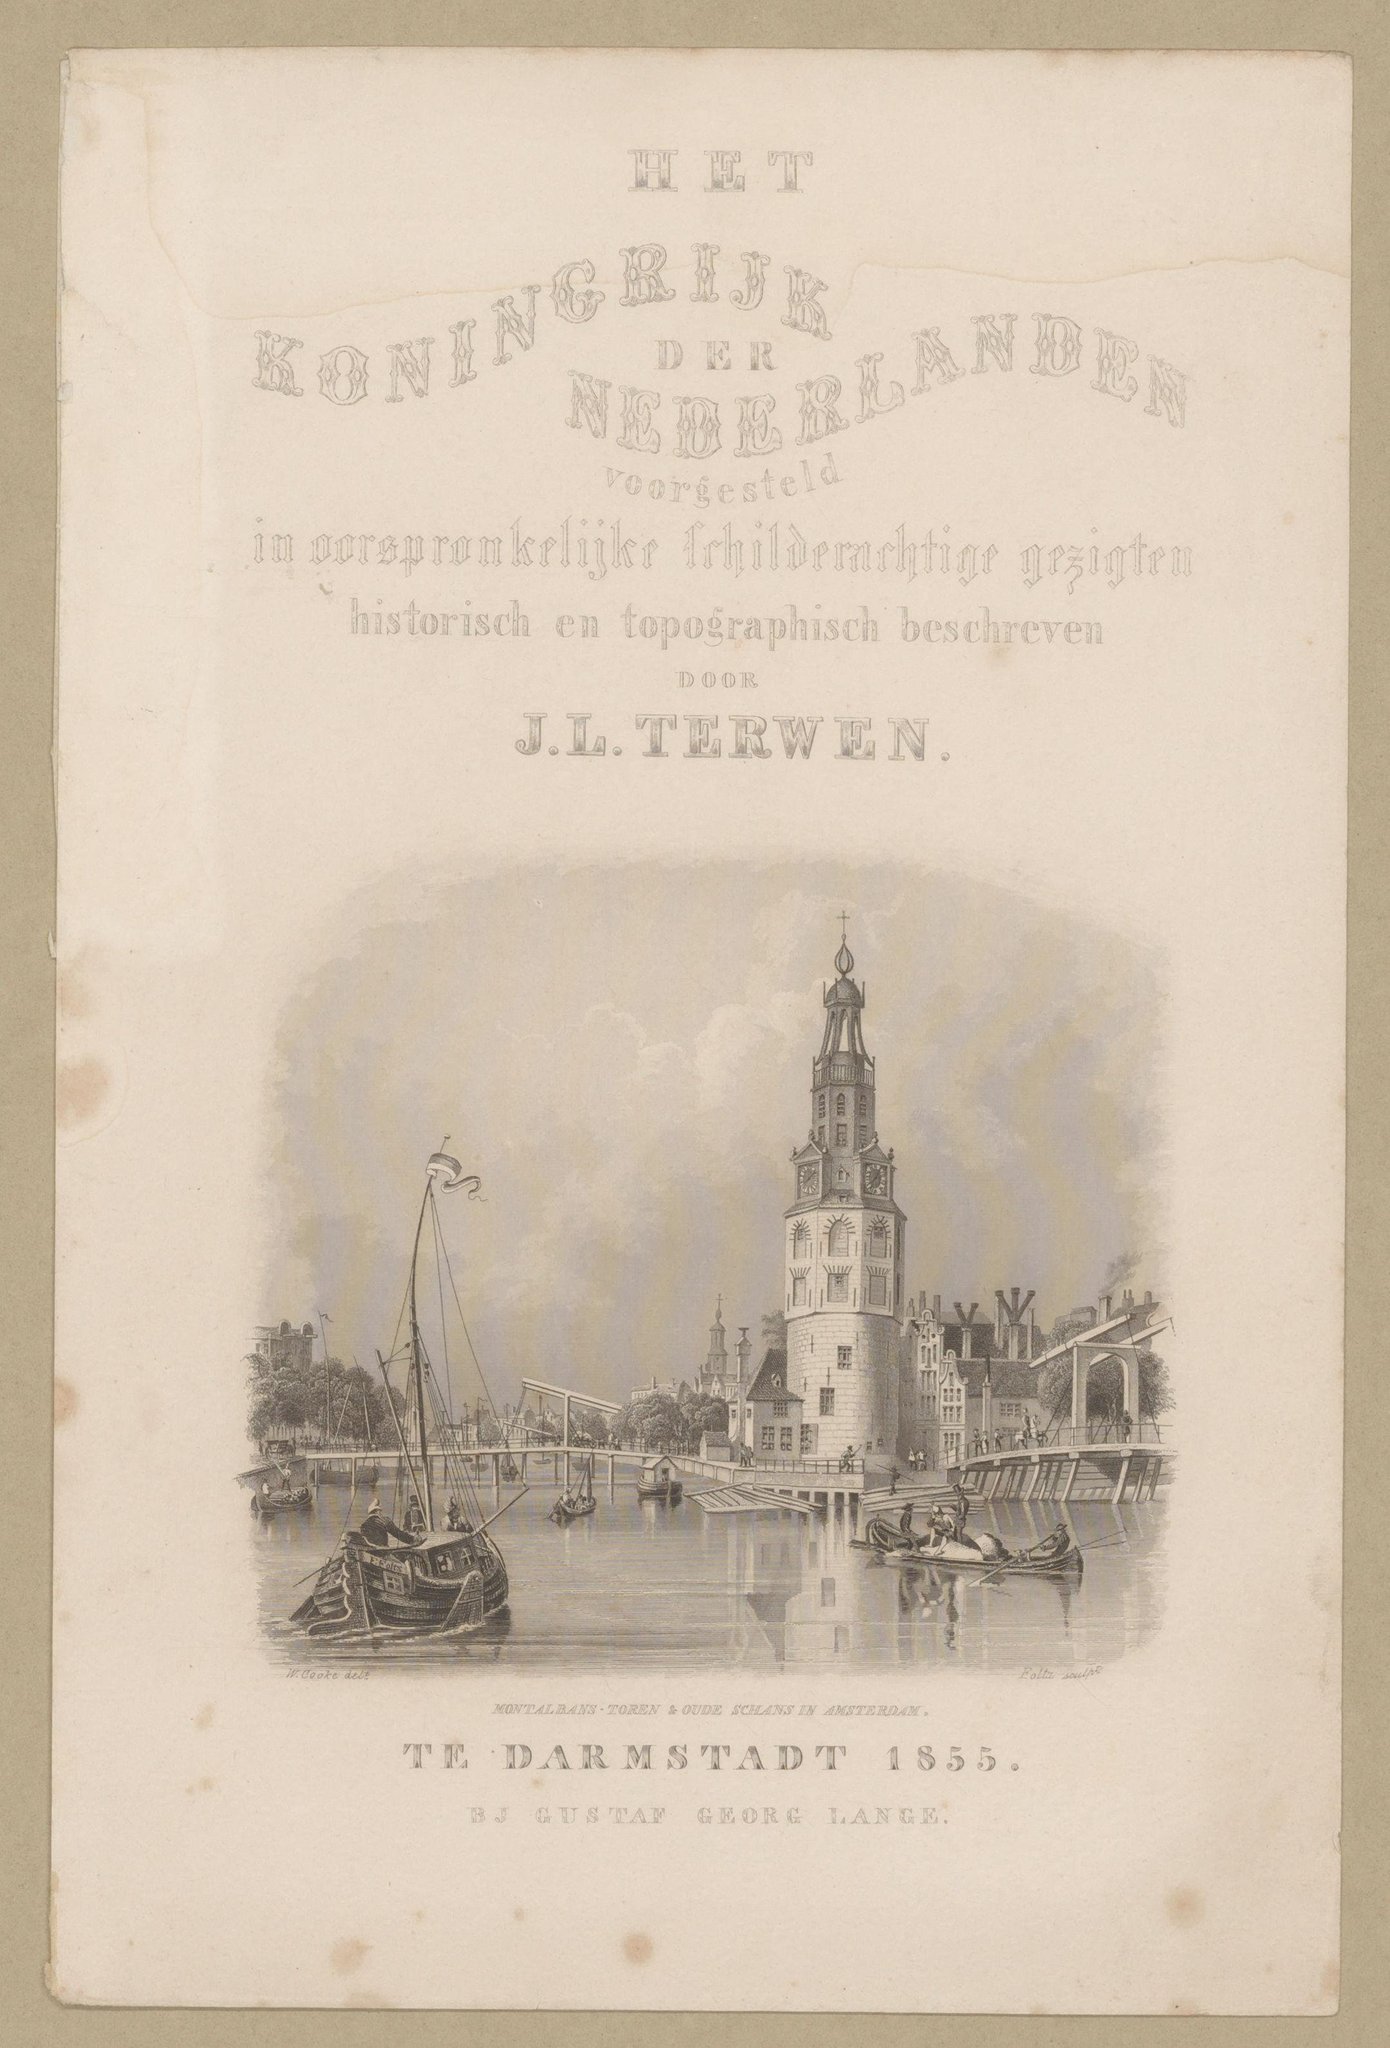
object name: print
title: Montalbans-Toren & Oude Schans in Amsterdam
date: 1855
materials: paper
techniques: engraving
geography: netherlands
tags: bridge in city across river, canal, etc. (+ city(-scape) with figures, staffage), sailing-ship, sailing-boat, tower, clock tower ~ monumental adornment, rowing-boat, canoe, etc.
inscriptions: collector's mark: Lugt 1641b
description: Titelpagina voor: Terwen, Johannes Leonardus. Het Koningrijk der Nederlanden voorgesteld in oorspronkelijke schilderachtige gezigten. Darmstadt: Gustav Georg Lange, 1855.